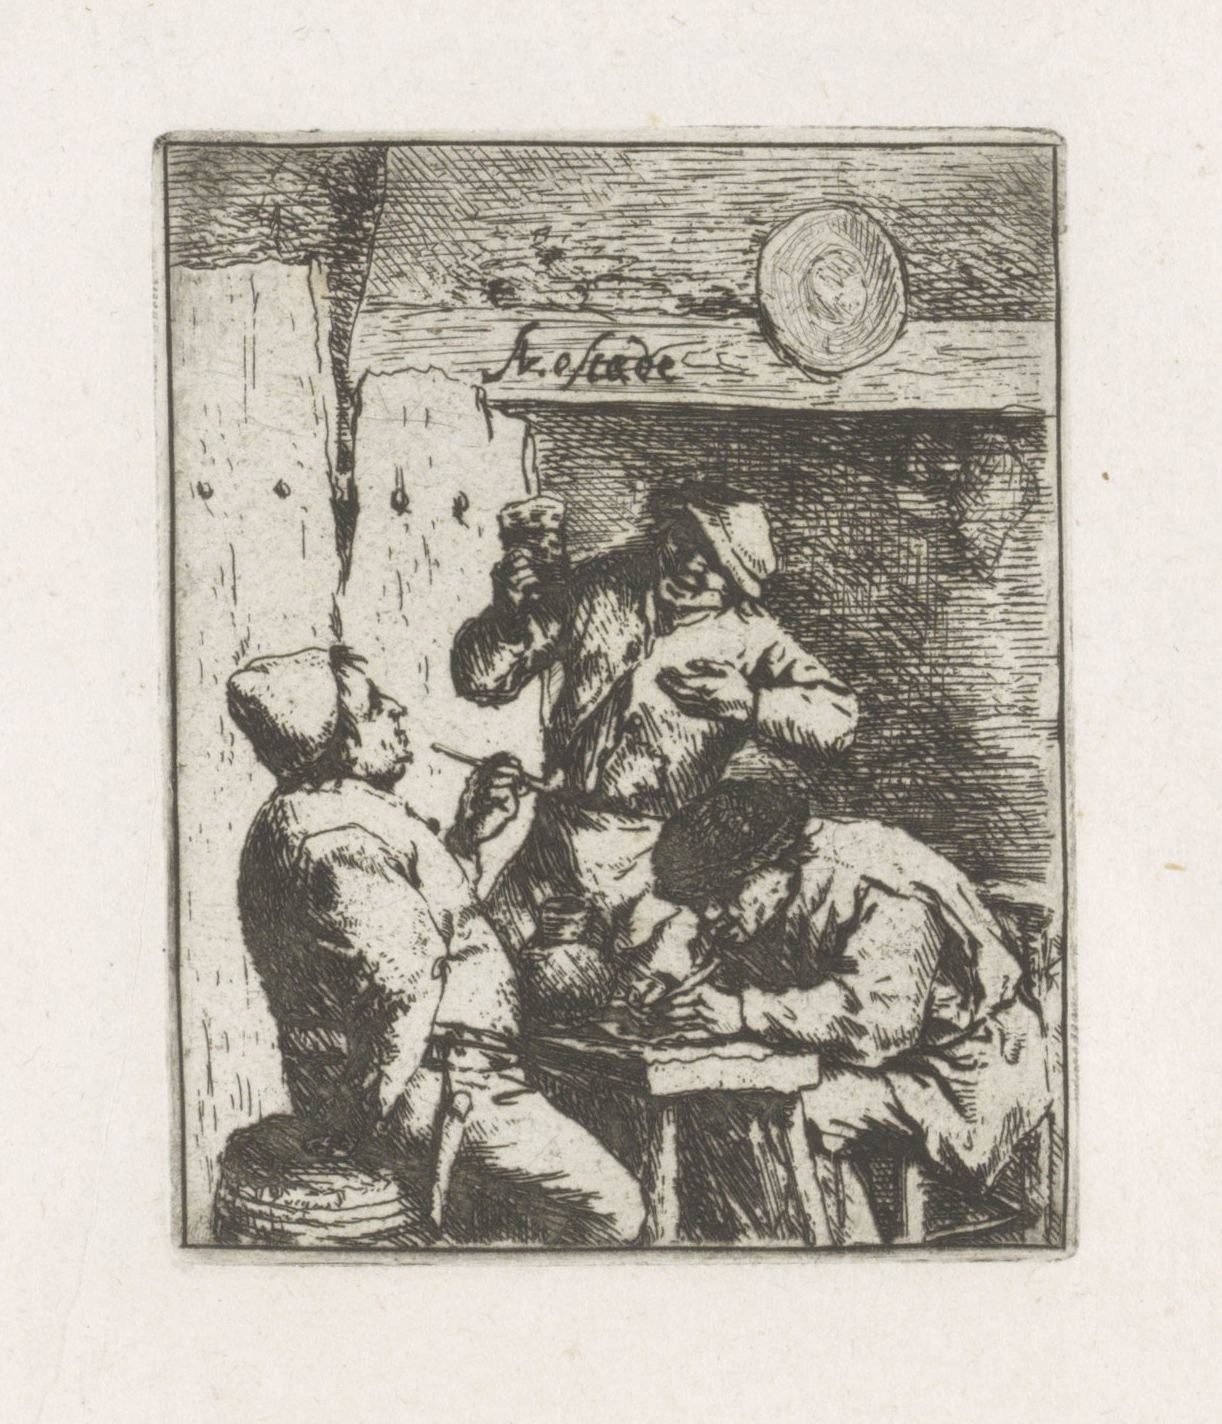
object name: print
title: Twee rokers en drinker in herberg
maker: adriaen van ostade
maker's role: draughtsman, painter, print maker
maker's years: 1610-1685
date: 1644-1648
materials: paper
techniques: etching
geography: haarlem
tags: inn, coffee-house, public house, etc., pipe ~ tobacco, drinking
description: Twee mannen zitten aan tafel in een herberg, beiden met een pijp in de hand. Een derde man staat met een drinkbeker voor een haard. Deze prent maakt deel uit van een album.